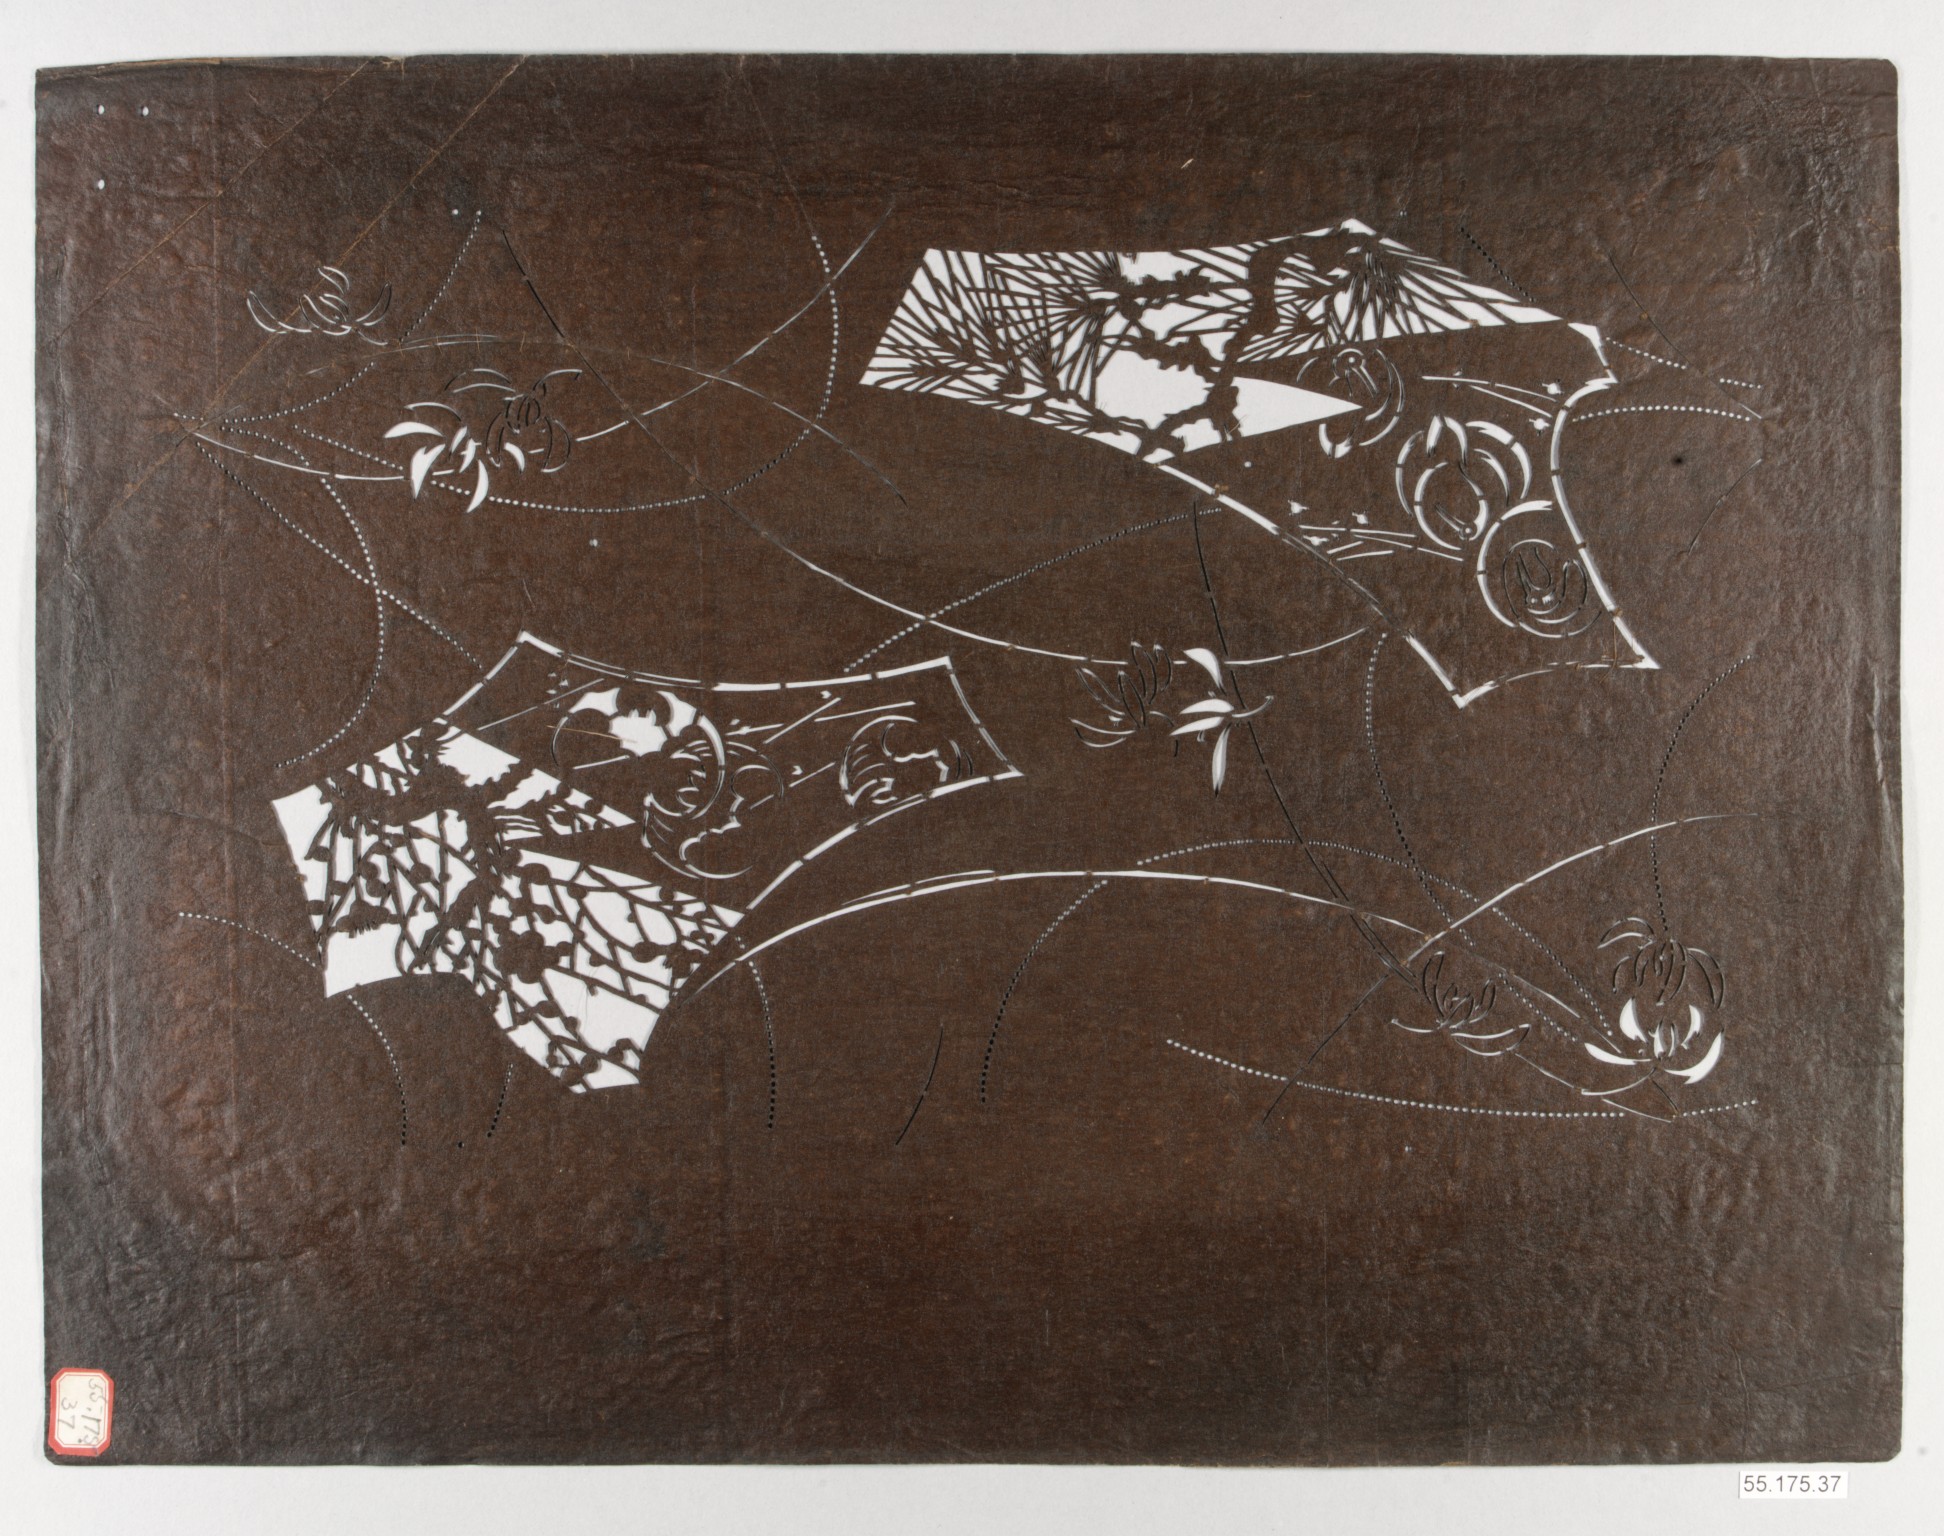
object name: stencil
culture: japanese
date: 1801-1900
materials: paper